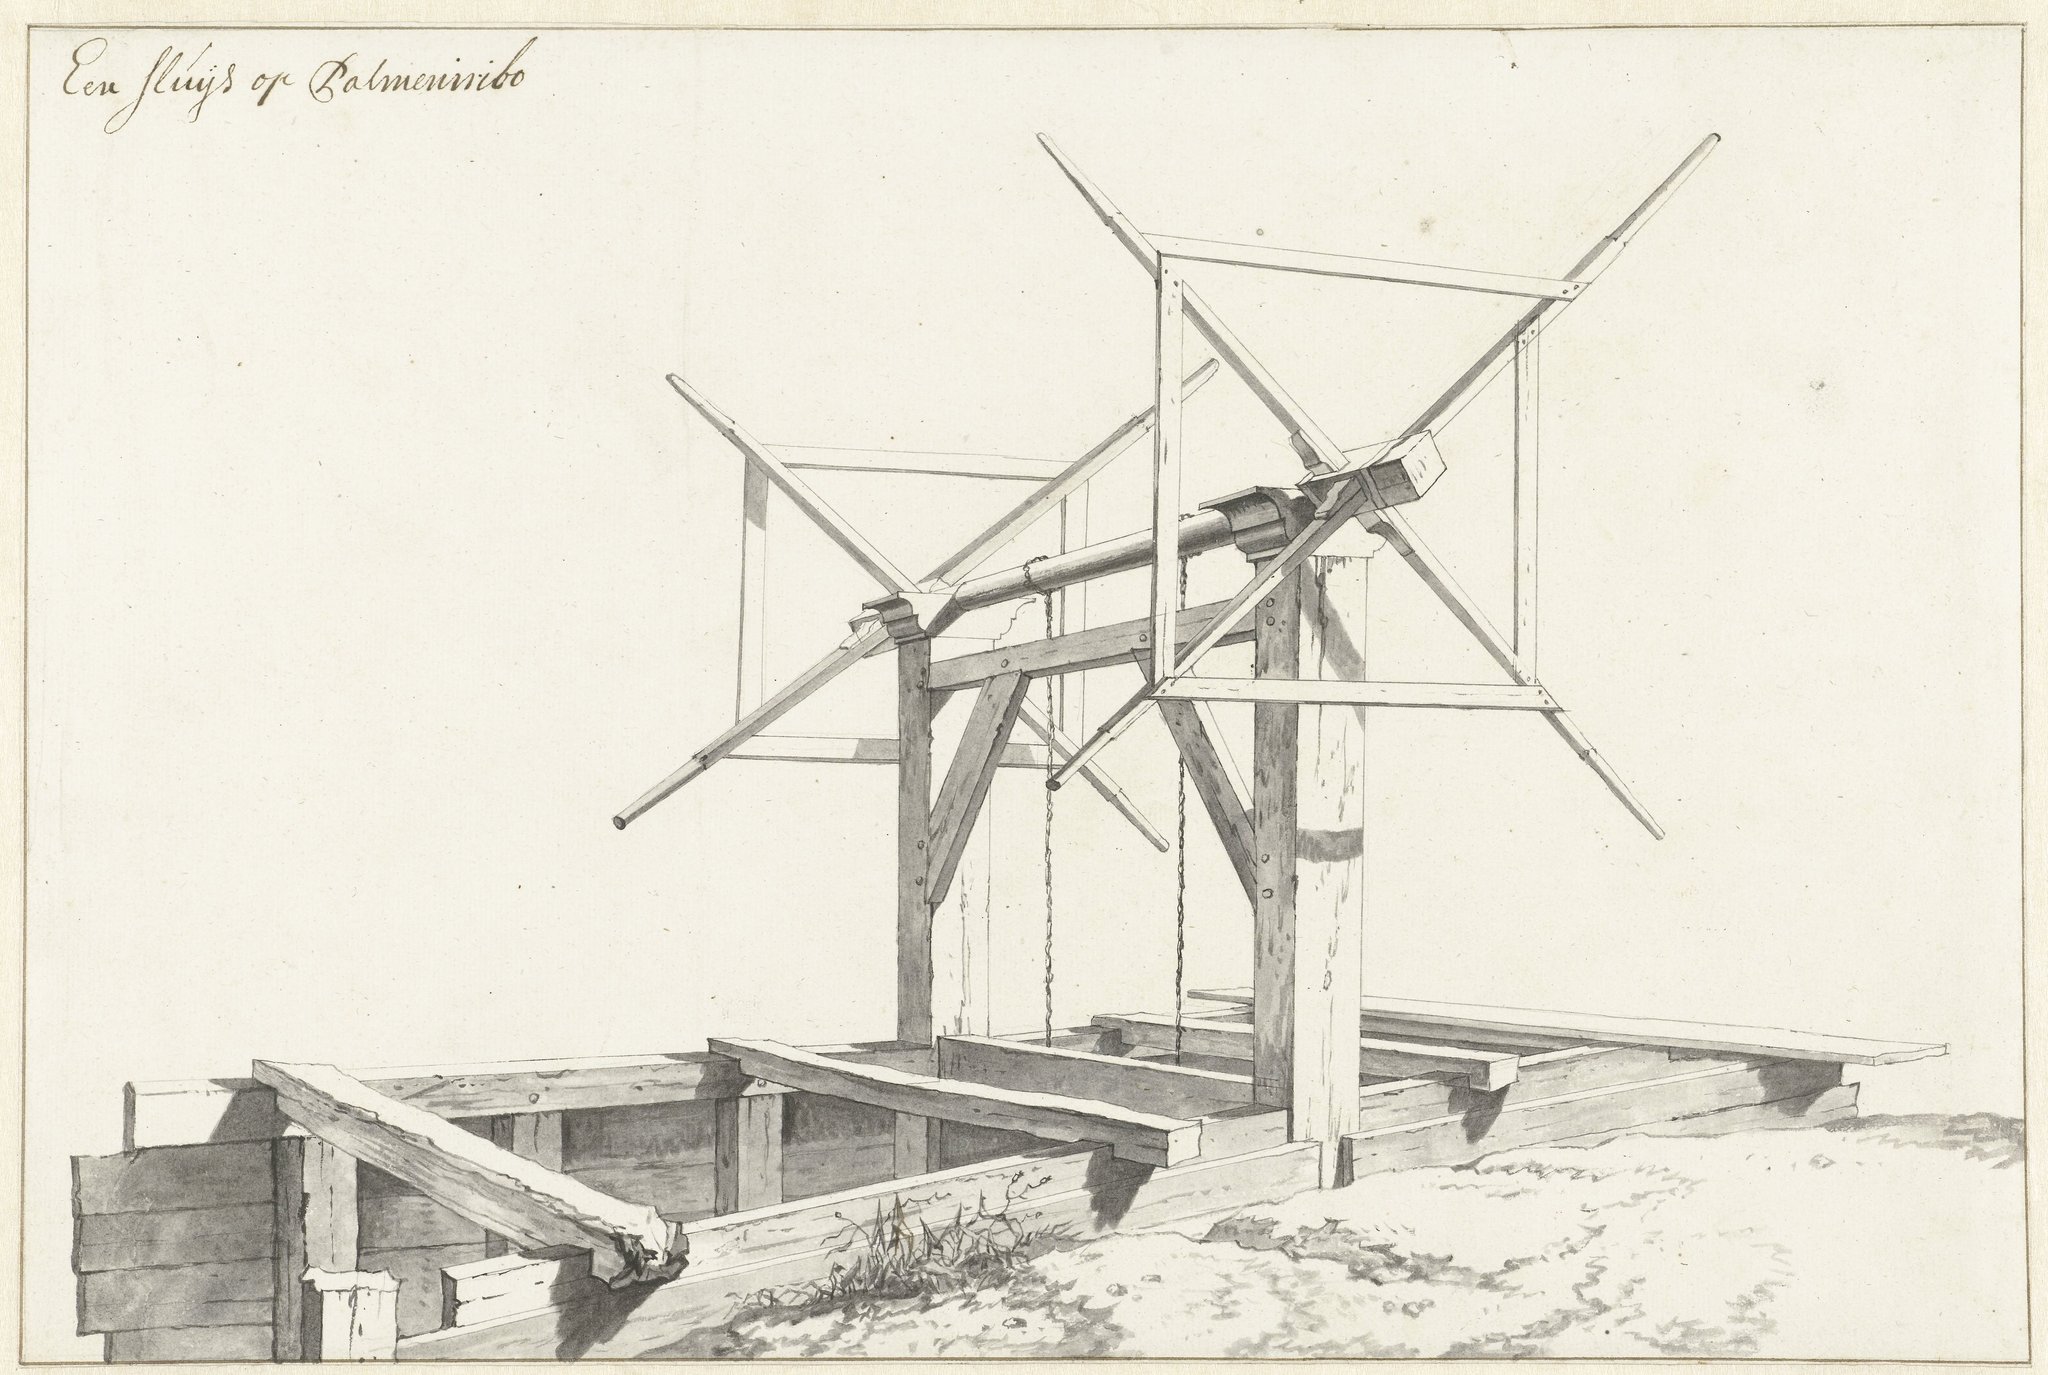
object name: drawing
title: Sluice on the Palmeneribo Plantation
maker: dirk valkenburg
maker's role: draughtsman, painter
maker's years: 1675-1721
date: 1708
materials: chalk, ink, paper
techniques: brush, pen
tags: sluice, weir, plantation, suriname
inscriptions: : ‘Een sluijs op Palmeniribo’, date: ‘1708’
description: Drawings of the Palmeneribo, Waterland and Surimombo Plantations. With the viewing instructions that Valken burg noted on his drawings, Witsen was able to take a virtual walk around his plantations. There are hardly any people in the drawings, except possibly Valkenburg himself on the doorstep of the residence on Surimombo. The artist seems to have a particular eye for the buildings and for the sluice, which was important to regulate the water level. The sugar cane fields are also missing. For Witsen, Valkenburg was not only a link between the two worlds, but also a filter.